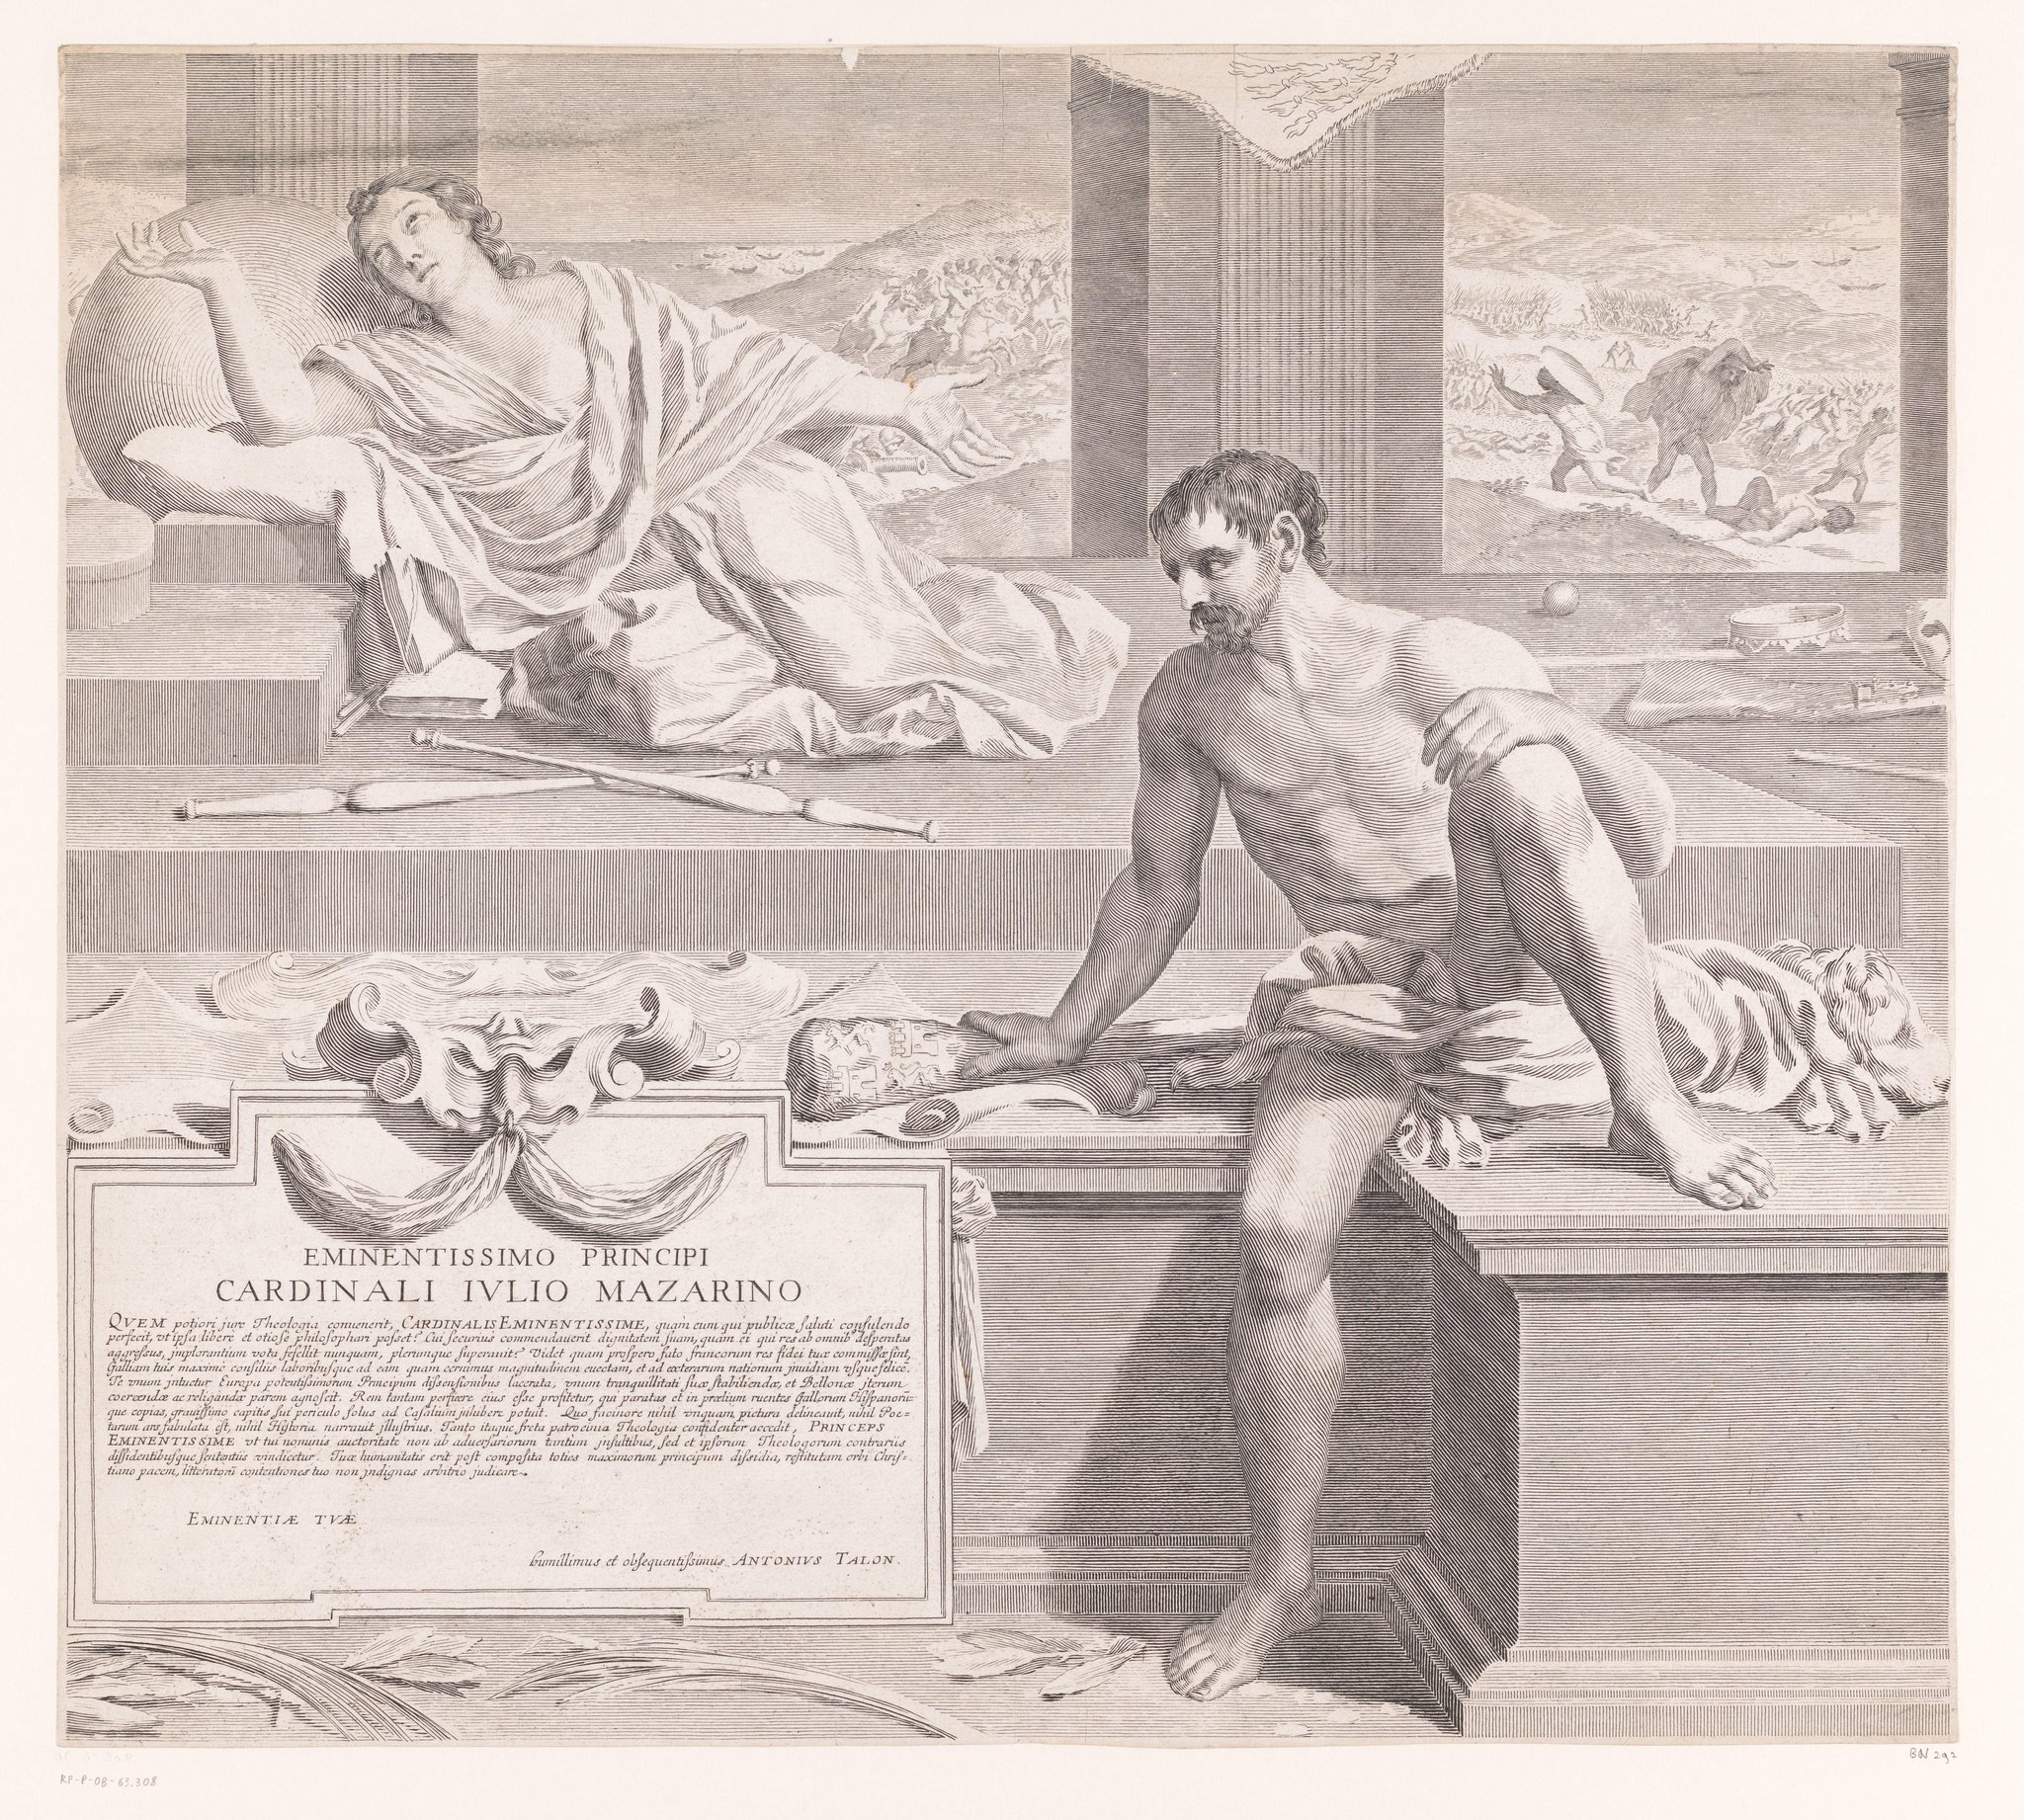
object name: print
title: These over theologie van Antoine Talon (rechtermiddendeel)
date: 1648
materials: paper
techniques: engraving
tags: (story of) hercules (heracles)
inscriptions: collector's mark: Lugt 2228